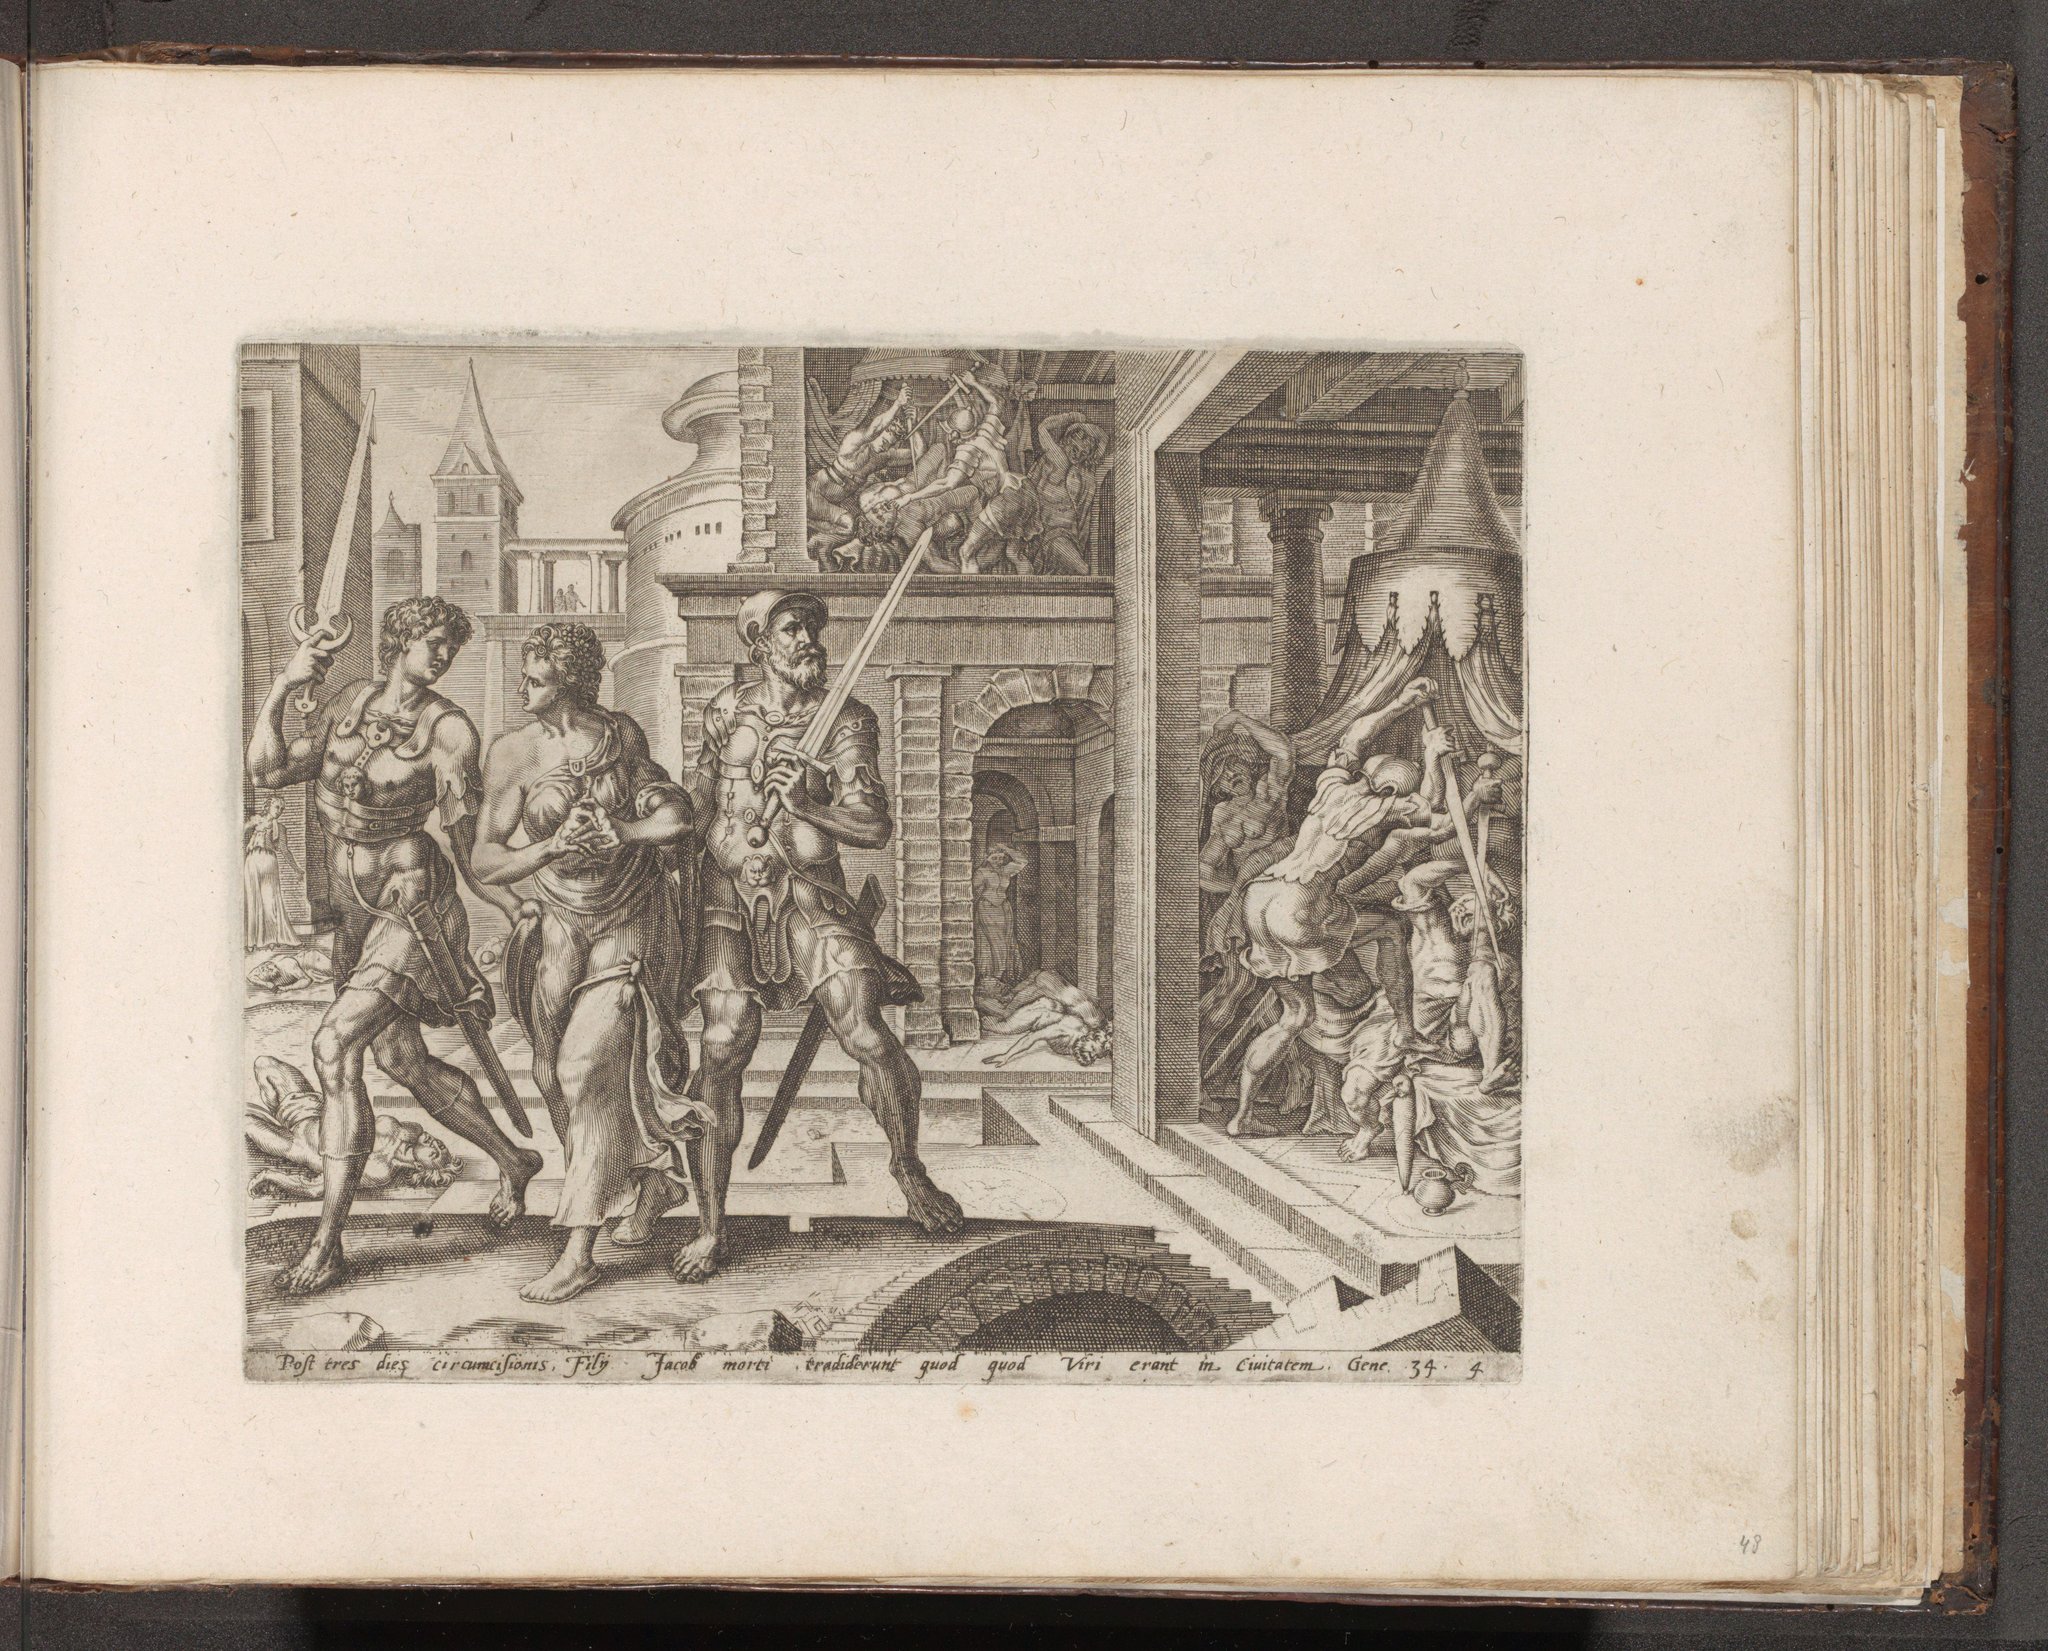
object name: print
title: Simeon en Levi nemen Dina mee naar huis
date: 1579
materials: paper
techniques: engraving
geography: amsterdam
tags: simeon and levi kill all the shechemites and bring dinah home, while the other brothers plunder the city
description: Simeon en Levi nemen hun zus Dina mee naar huis, nadat zij wraak hebben genomen op Sichem, die hun zus had onteerd. Op de achtergrond doden de broers Sichem en zijn mannen, die na hun besnijdenis koortsig waren en niet terug konden vechten. Onderaan in de marge een verwijzing in het Latijn naar de Bijbeltekst in Gen. 34. Prent maakt deel uit van een album.